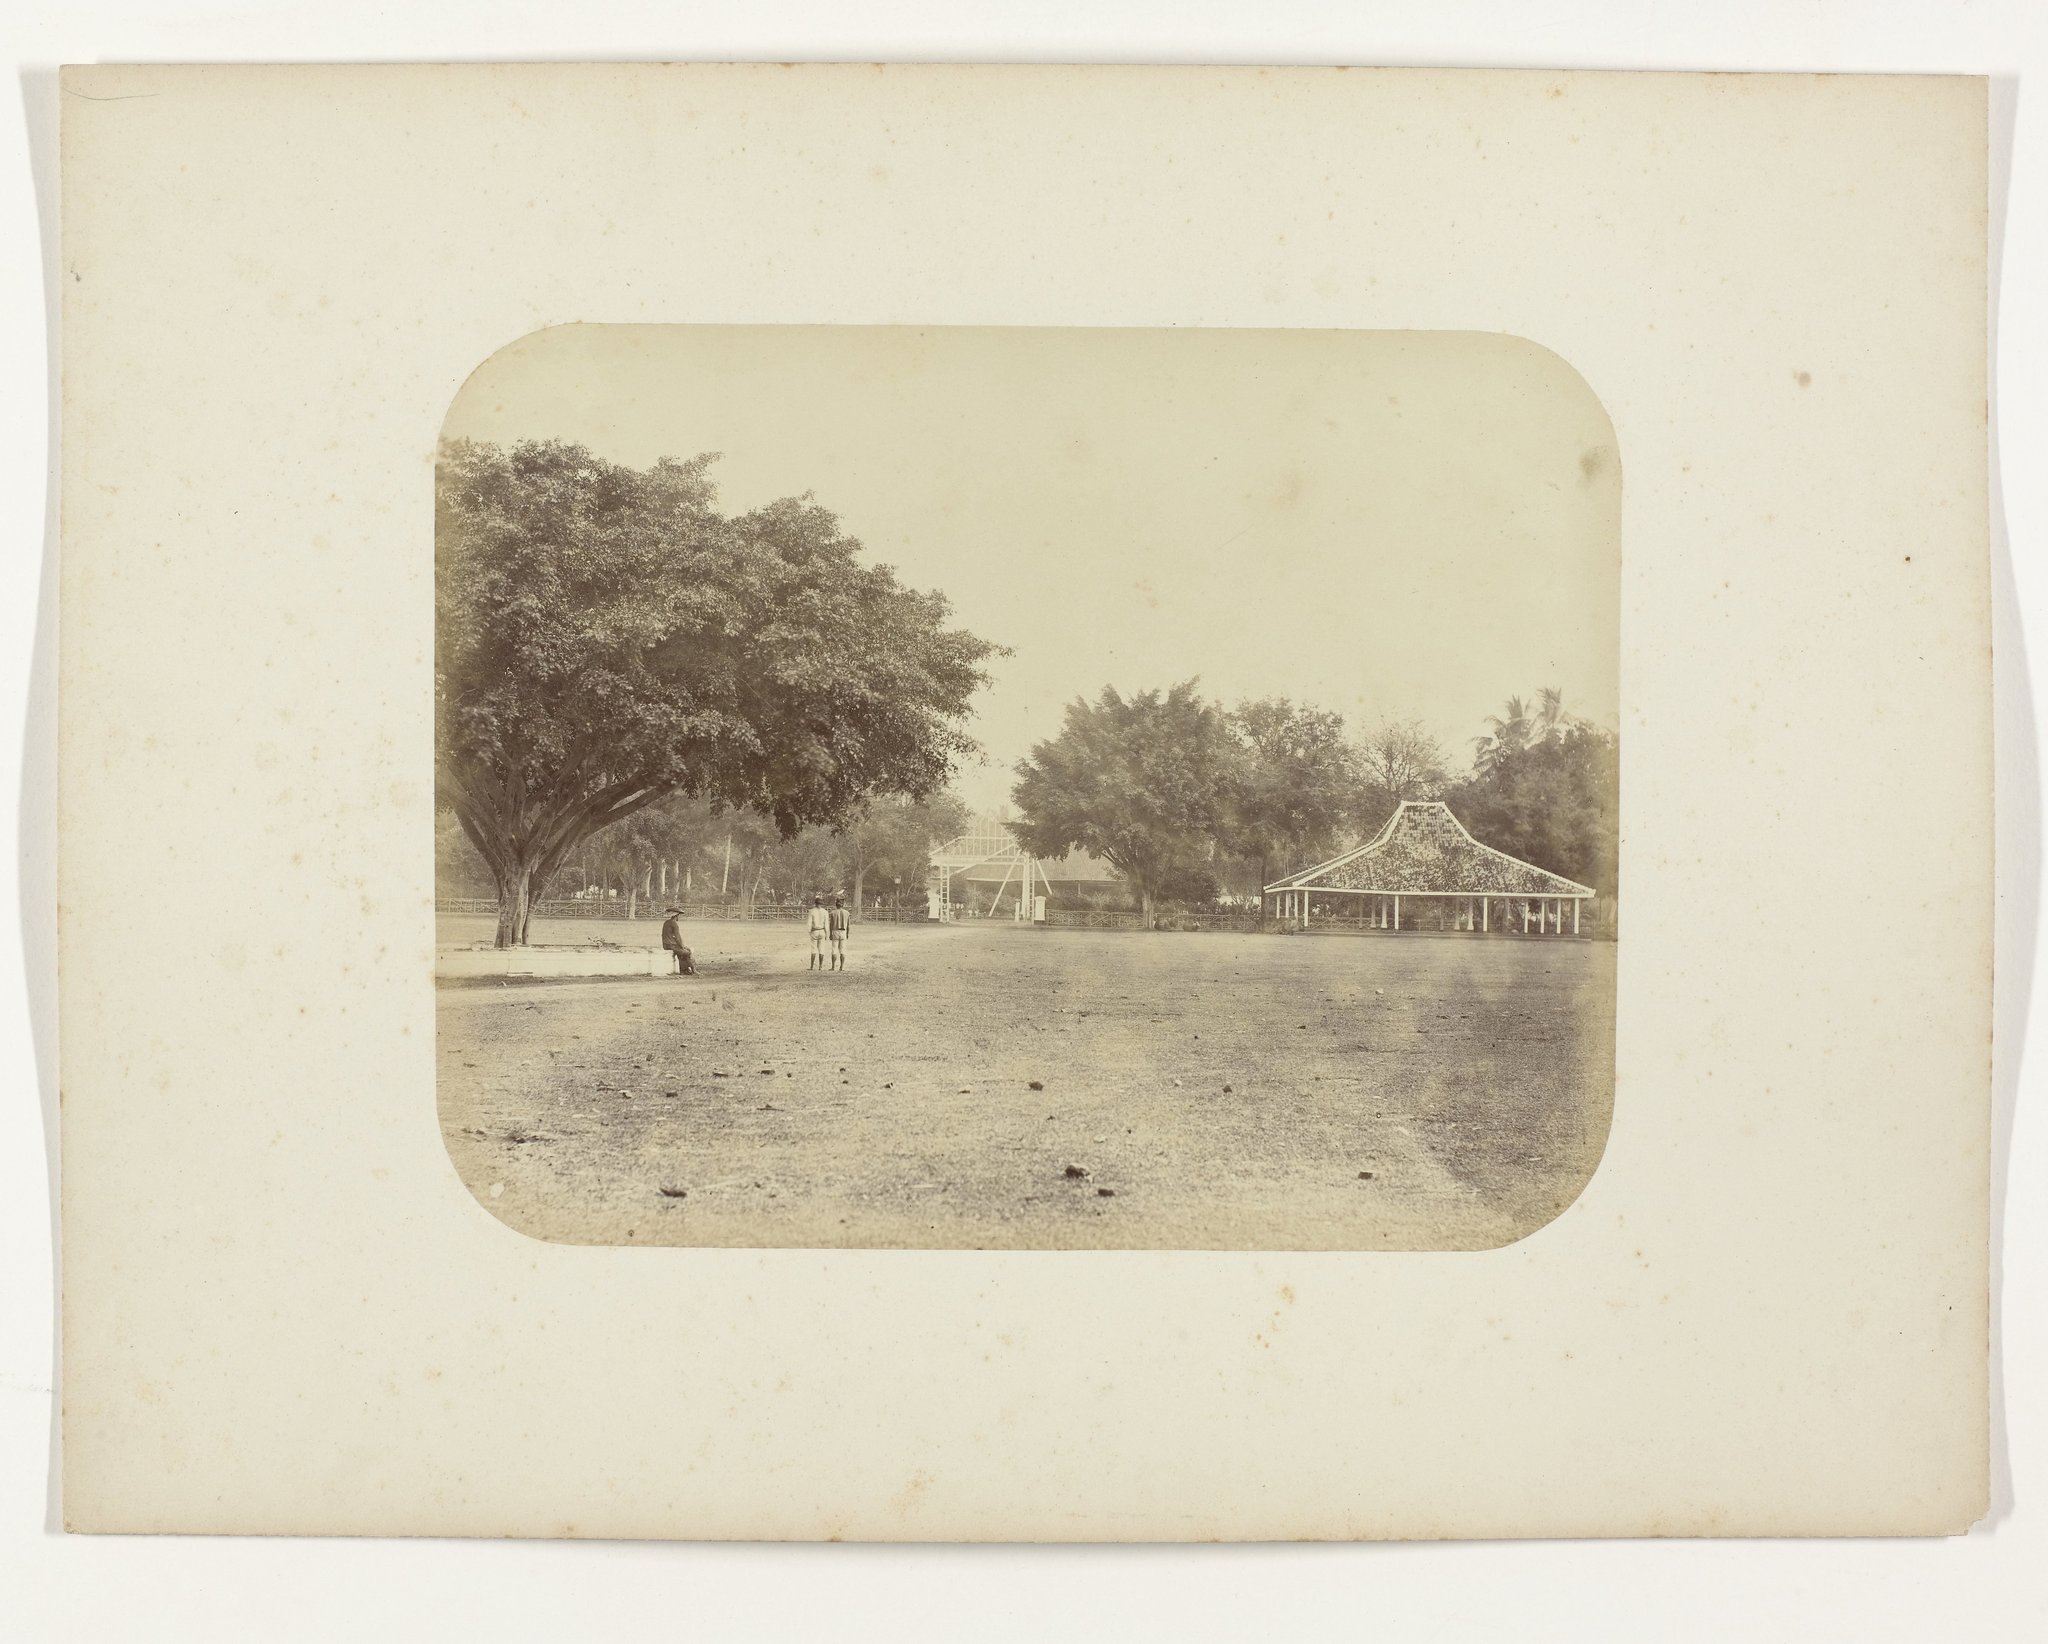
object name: photograph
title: Een ingang naar de Kratan, het paleis van de sultan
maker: herman salzwedel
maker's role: fotograaf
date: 1876-1884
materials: photographic support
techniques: albumen print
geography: surabaya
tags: utrecht, the hague, colonial system, palace, java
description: Een ingang naar de Kratan, het paleis van de sultan. Op de voorgrond een groot grasveld met links een boom met drie inlanders. Op de achtergrond de ingang tot het paleis. Onderdeel van het fotoalbum door de Soerabayasche Vereeniging van Suikerfabrikanten aangeboden aan Frederik Beyerinck, resident van Soerabaja.